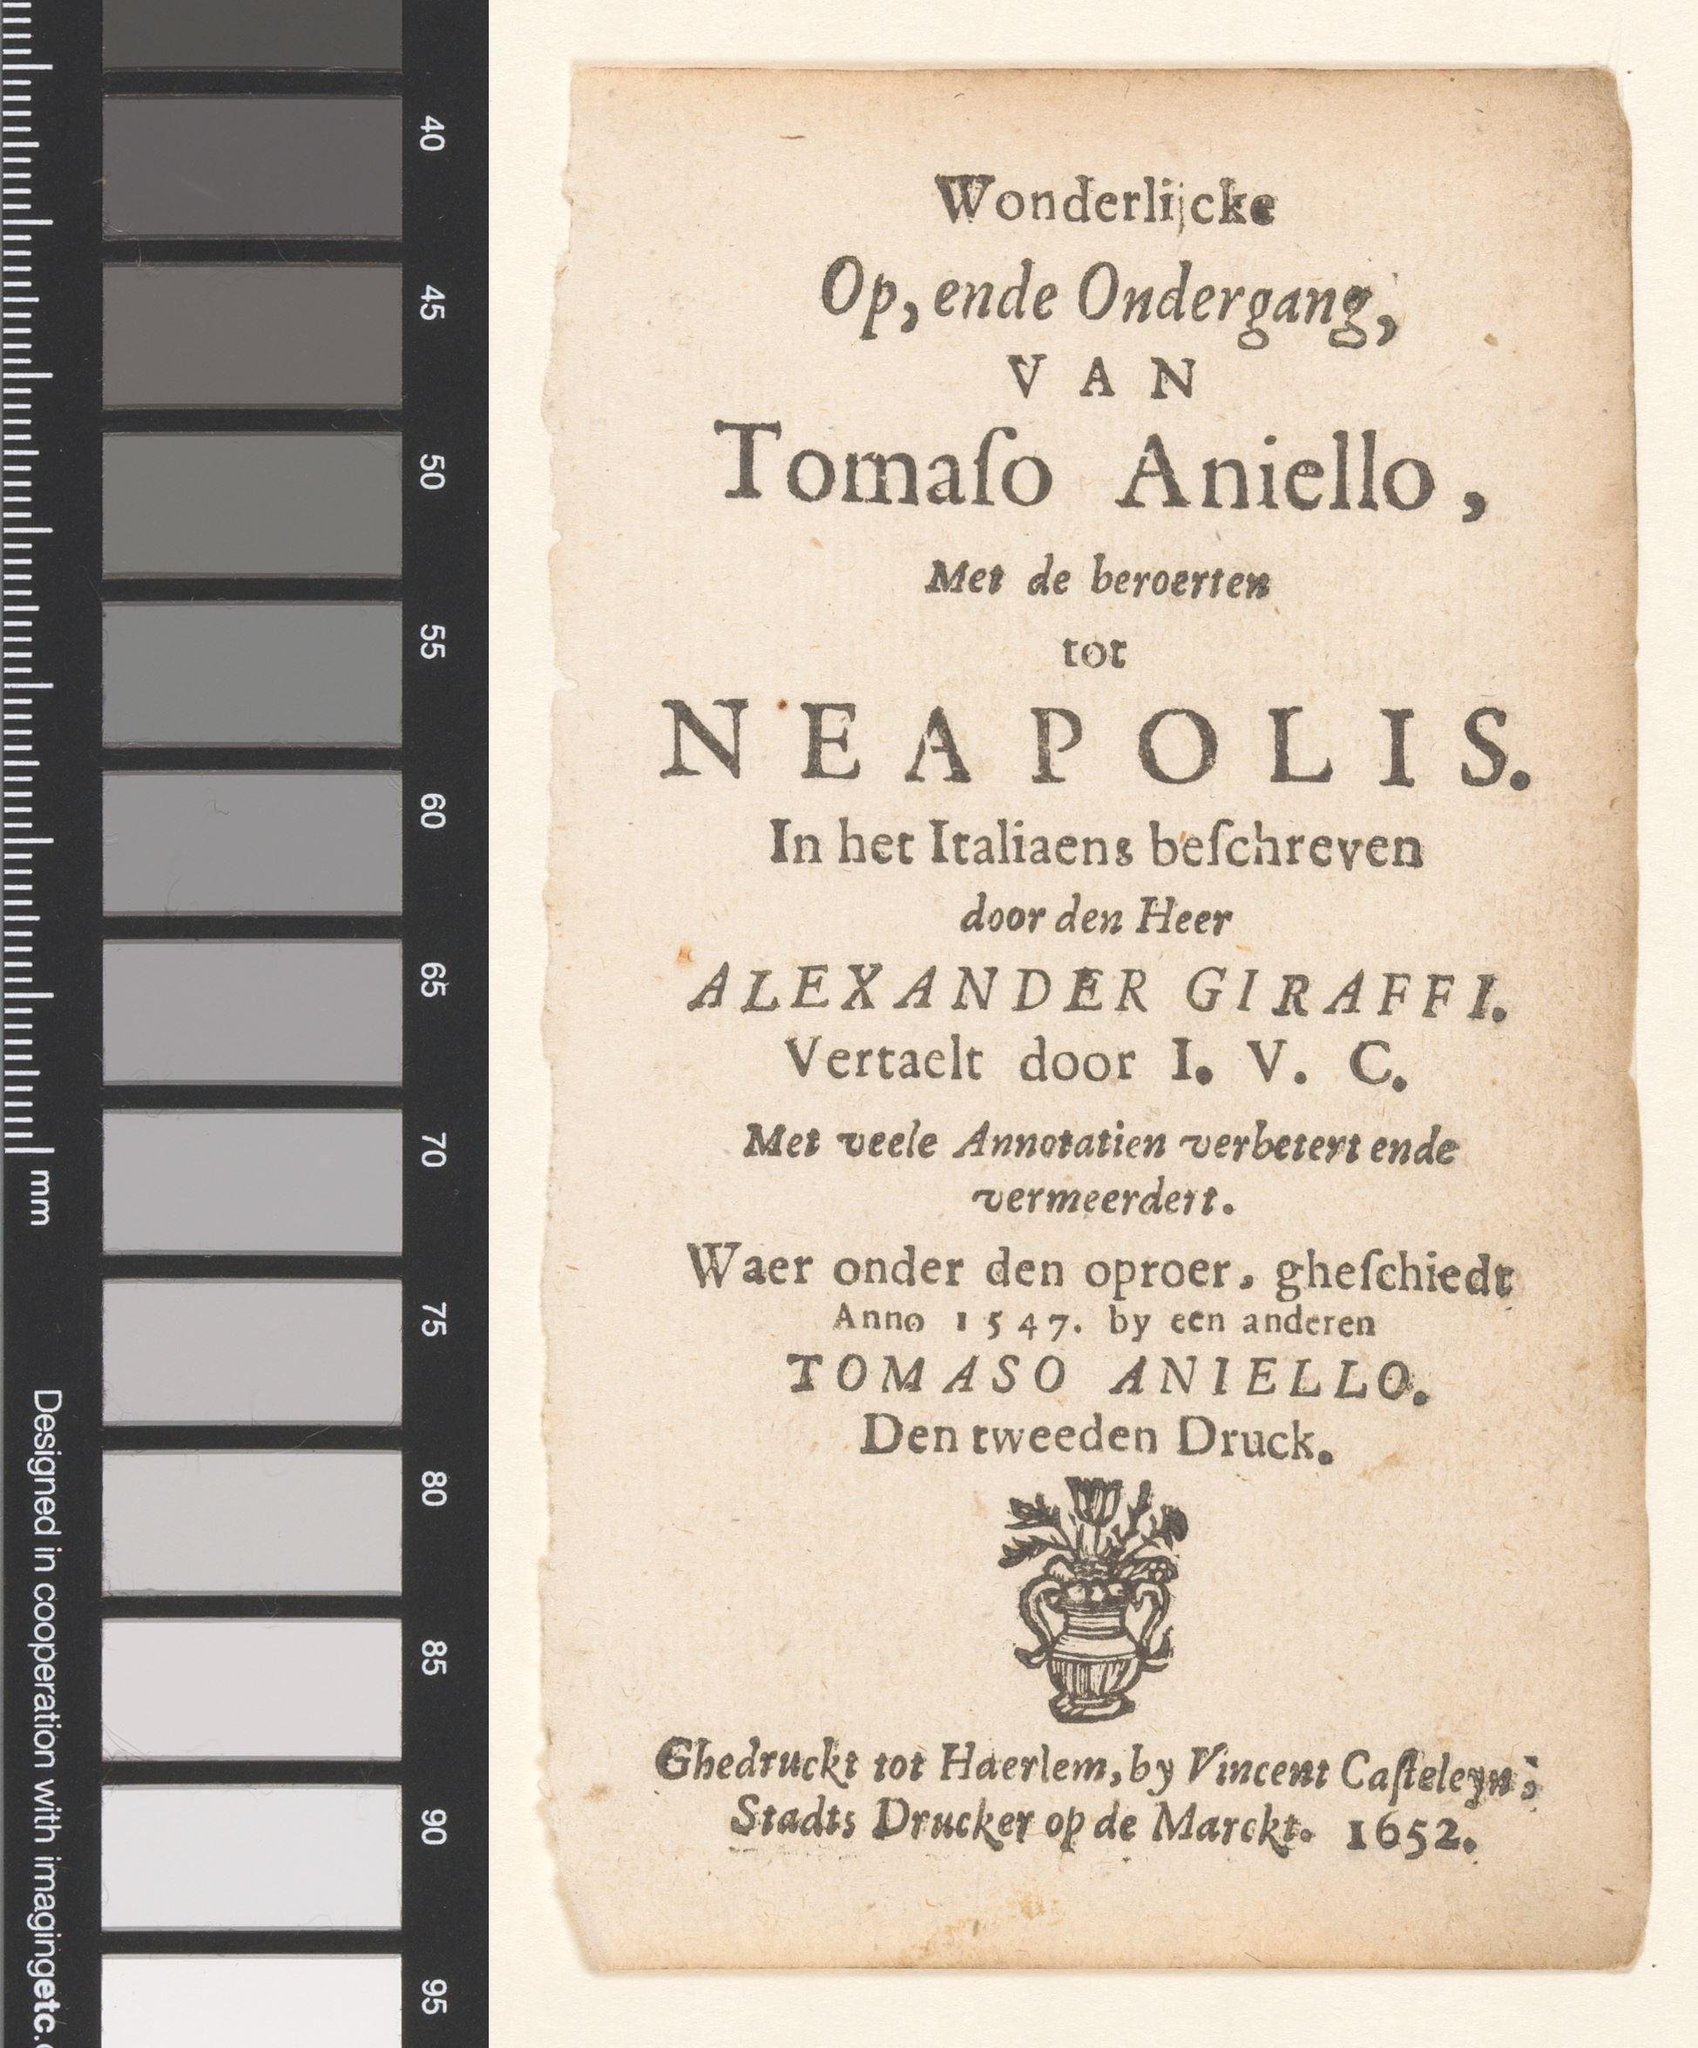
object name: print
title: Vaas met bloemen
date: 1652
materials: paper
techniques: letterpress printing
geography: haarlem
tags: flowers in a vase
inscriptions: collector's mark: Lugt 2228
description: Titelpagina voor: Giraffi, Alexander. Wonderlijcken Op, ende Ondergang, van Tomaso Aniello, Met de beroerten tot Neapolis. Haarlem: Casteleyn, Vincent 1652.